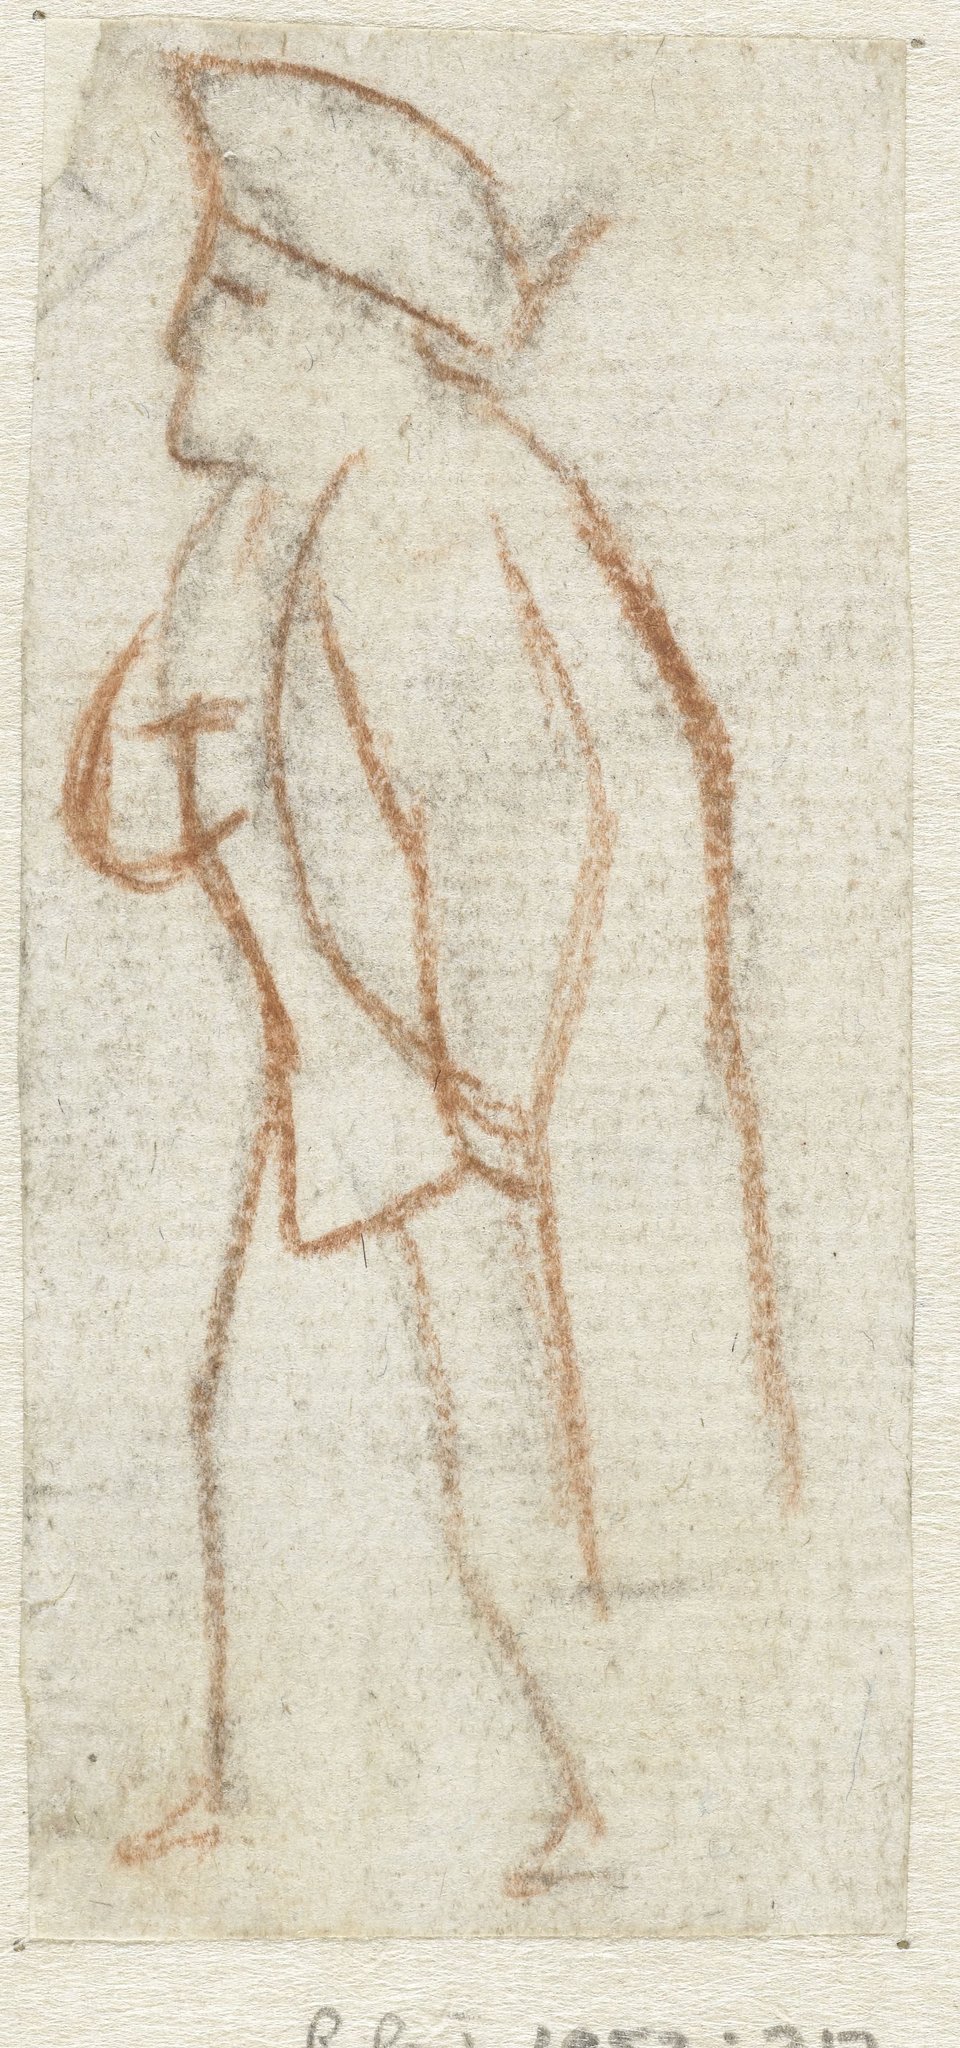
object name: drawing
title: Lopende man, naar links, van opzij gezien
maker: simon andreas krausz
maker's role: draughtsman, print maker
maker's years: 1760-1825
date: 1770-1825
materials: chalk, paper